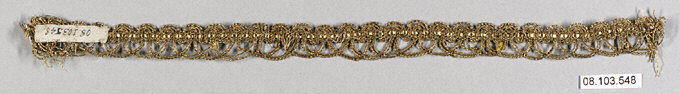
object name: galloon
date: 1701-1800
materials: metal thread